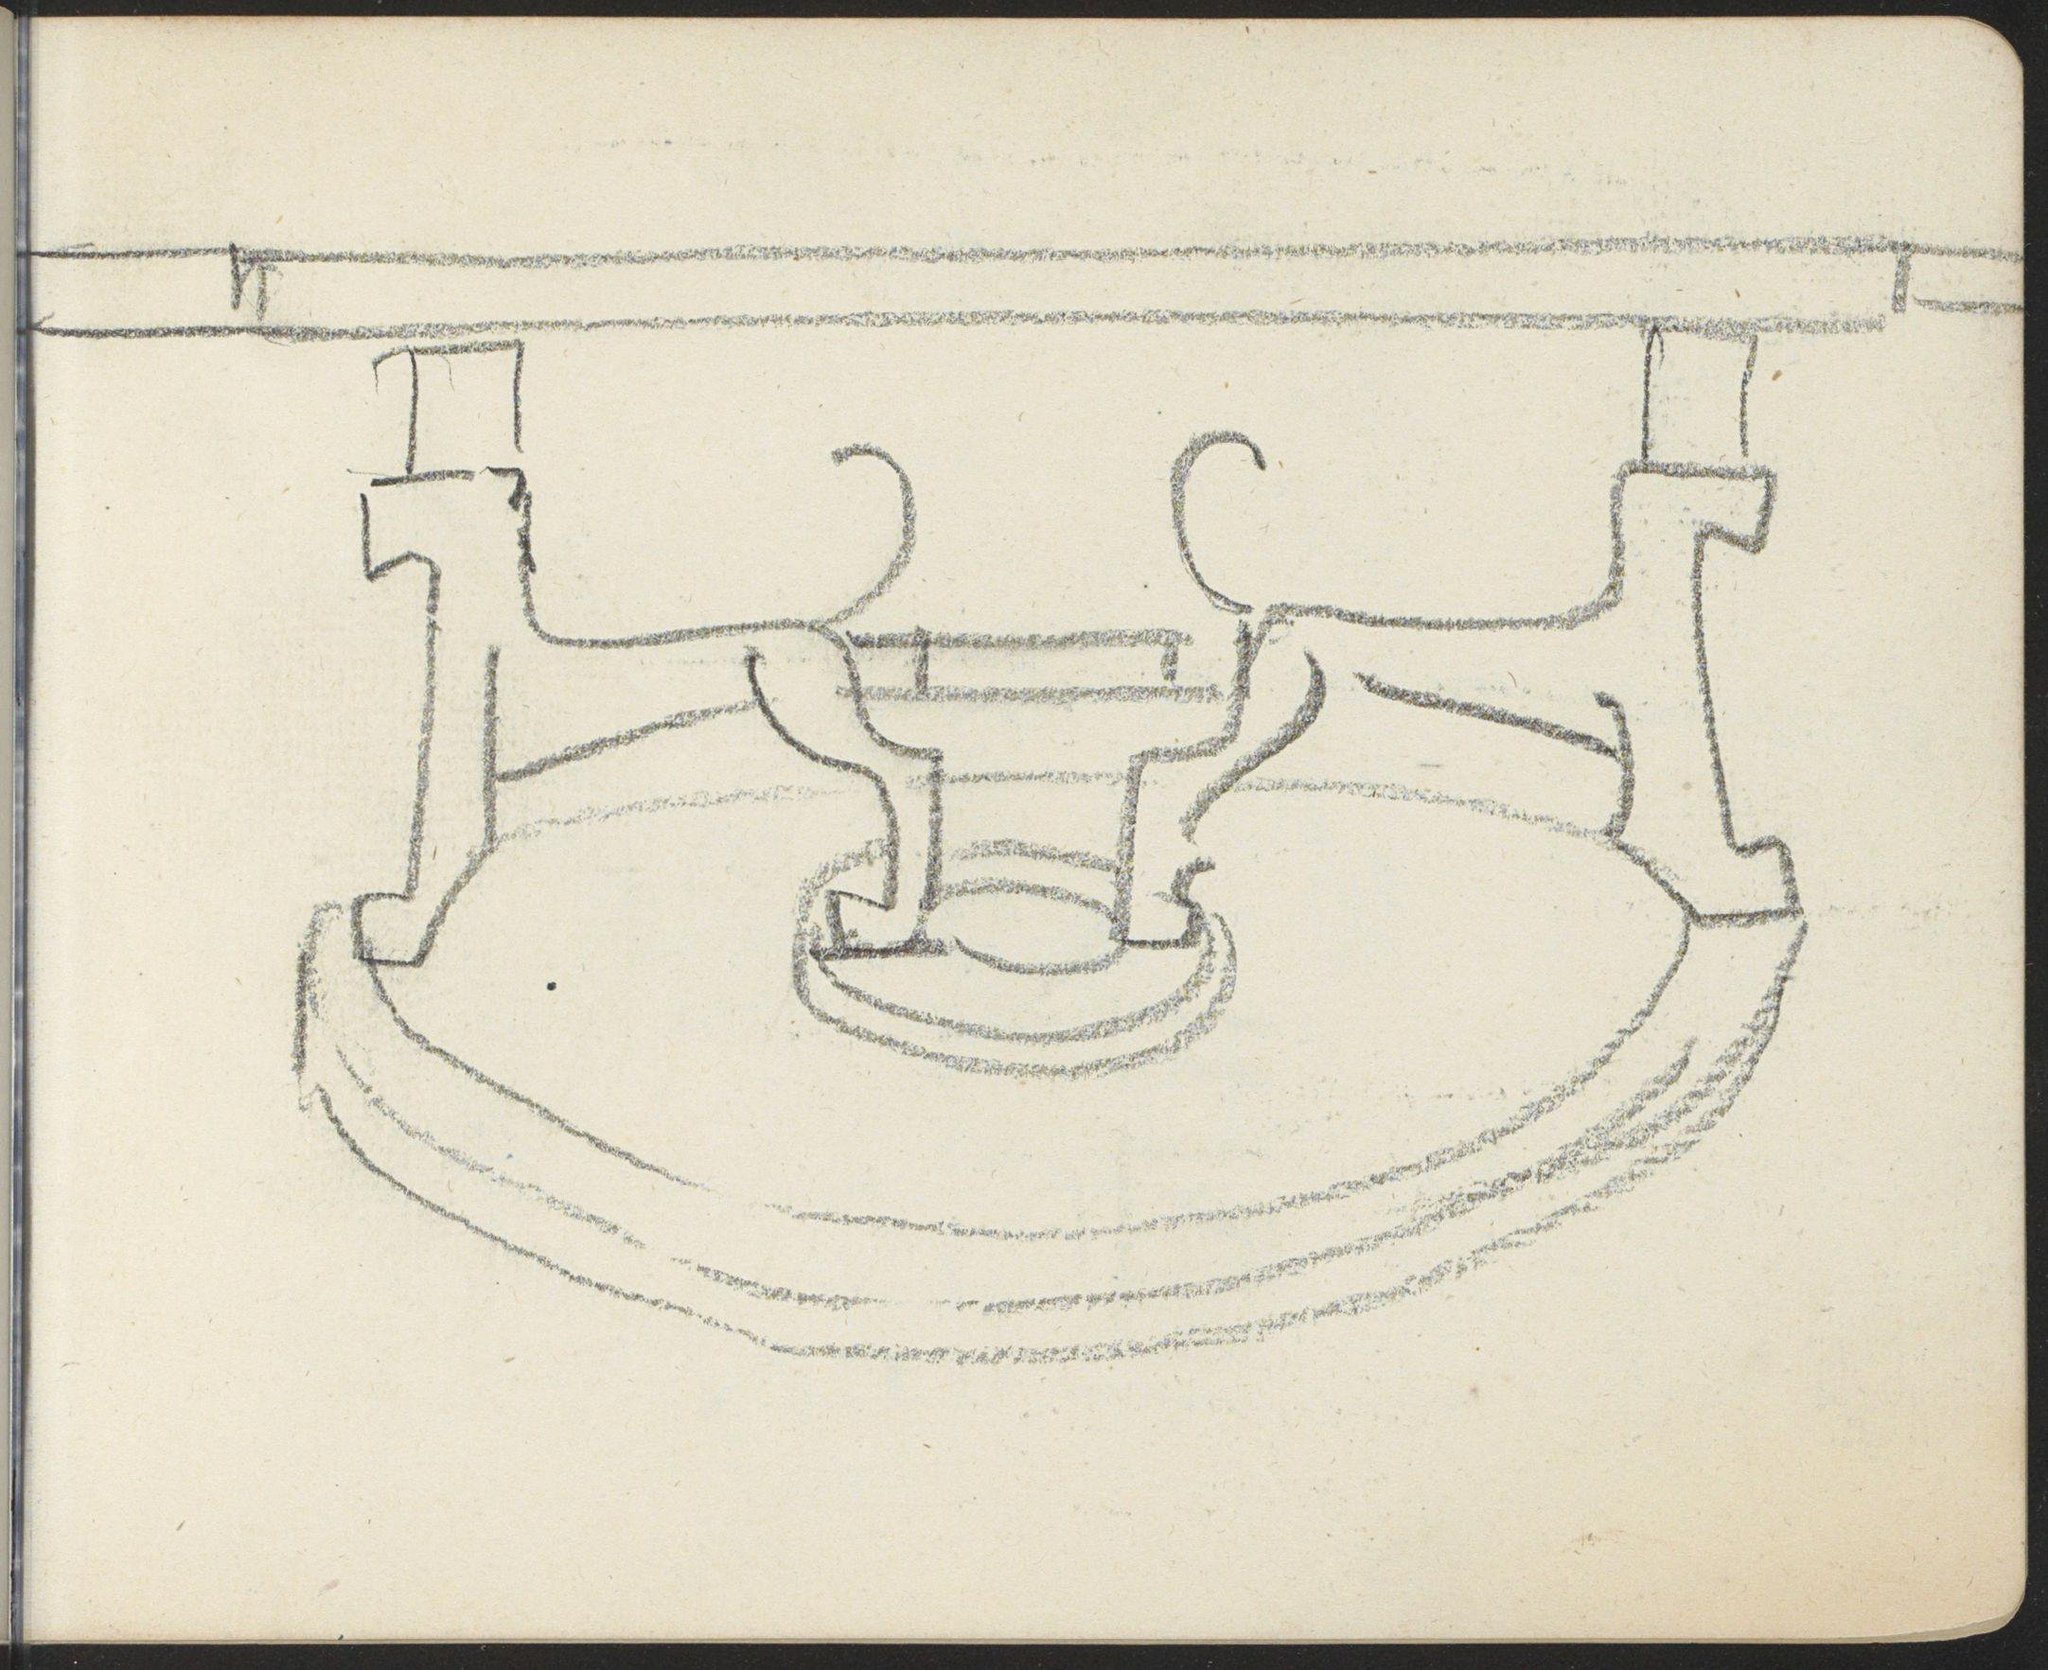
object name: sketchbook leaf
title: Ontwerp voor een meubel, vermoedelijk een tafel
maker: carel adolph lion cachet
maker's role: draughtsman, print maker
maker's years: 1864-1945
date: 1928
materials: paper, pencil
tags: table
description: Blad 7 recto uit een schetsboek met 24 bladen.